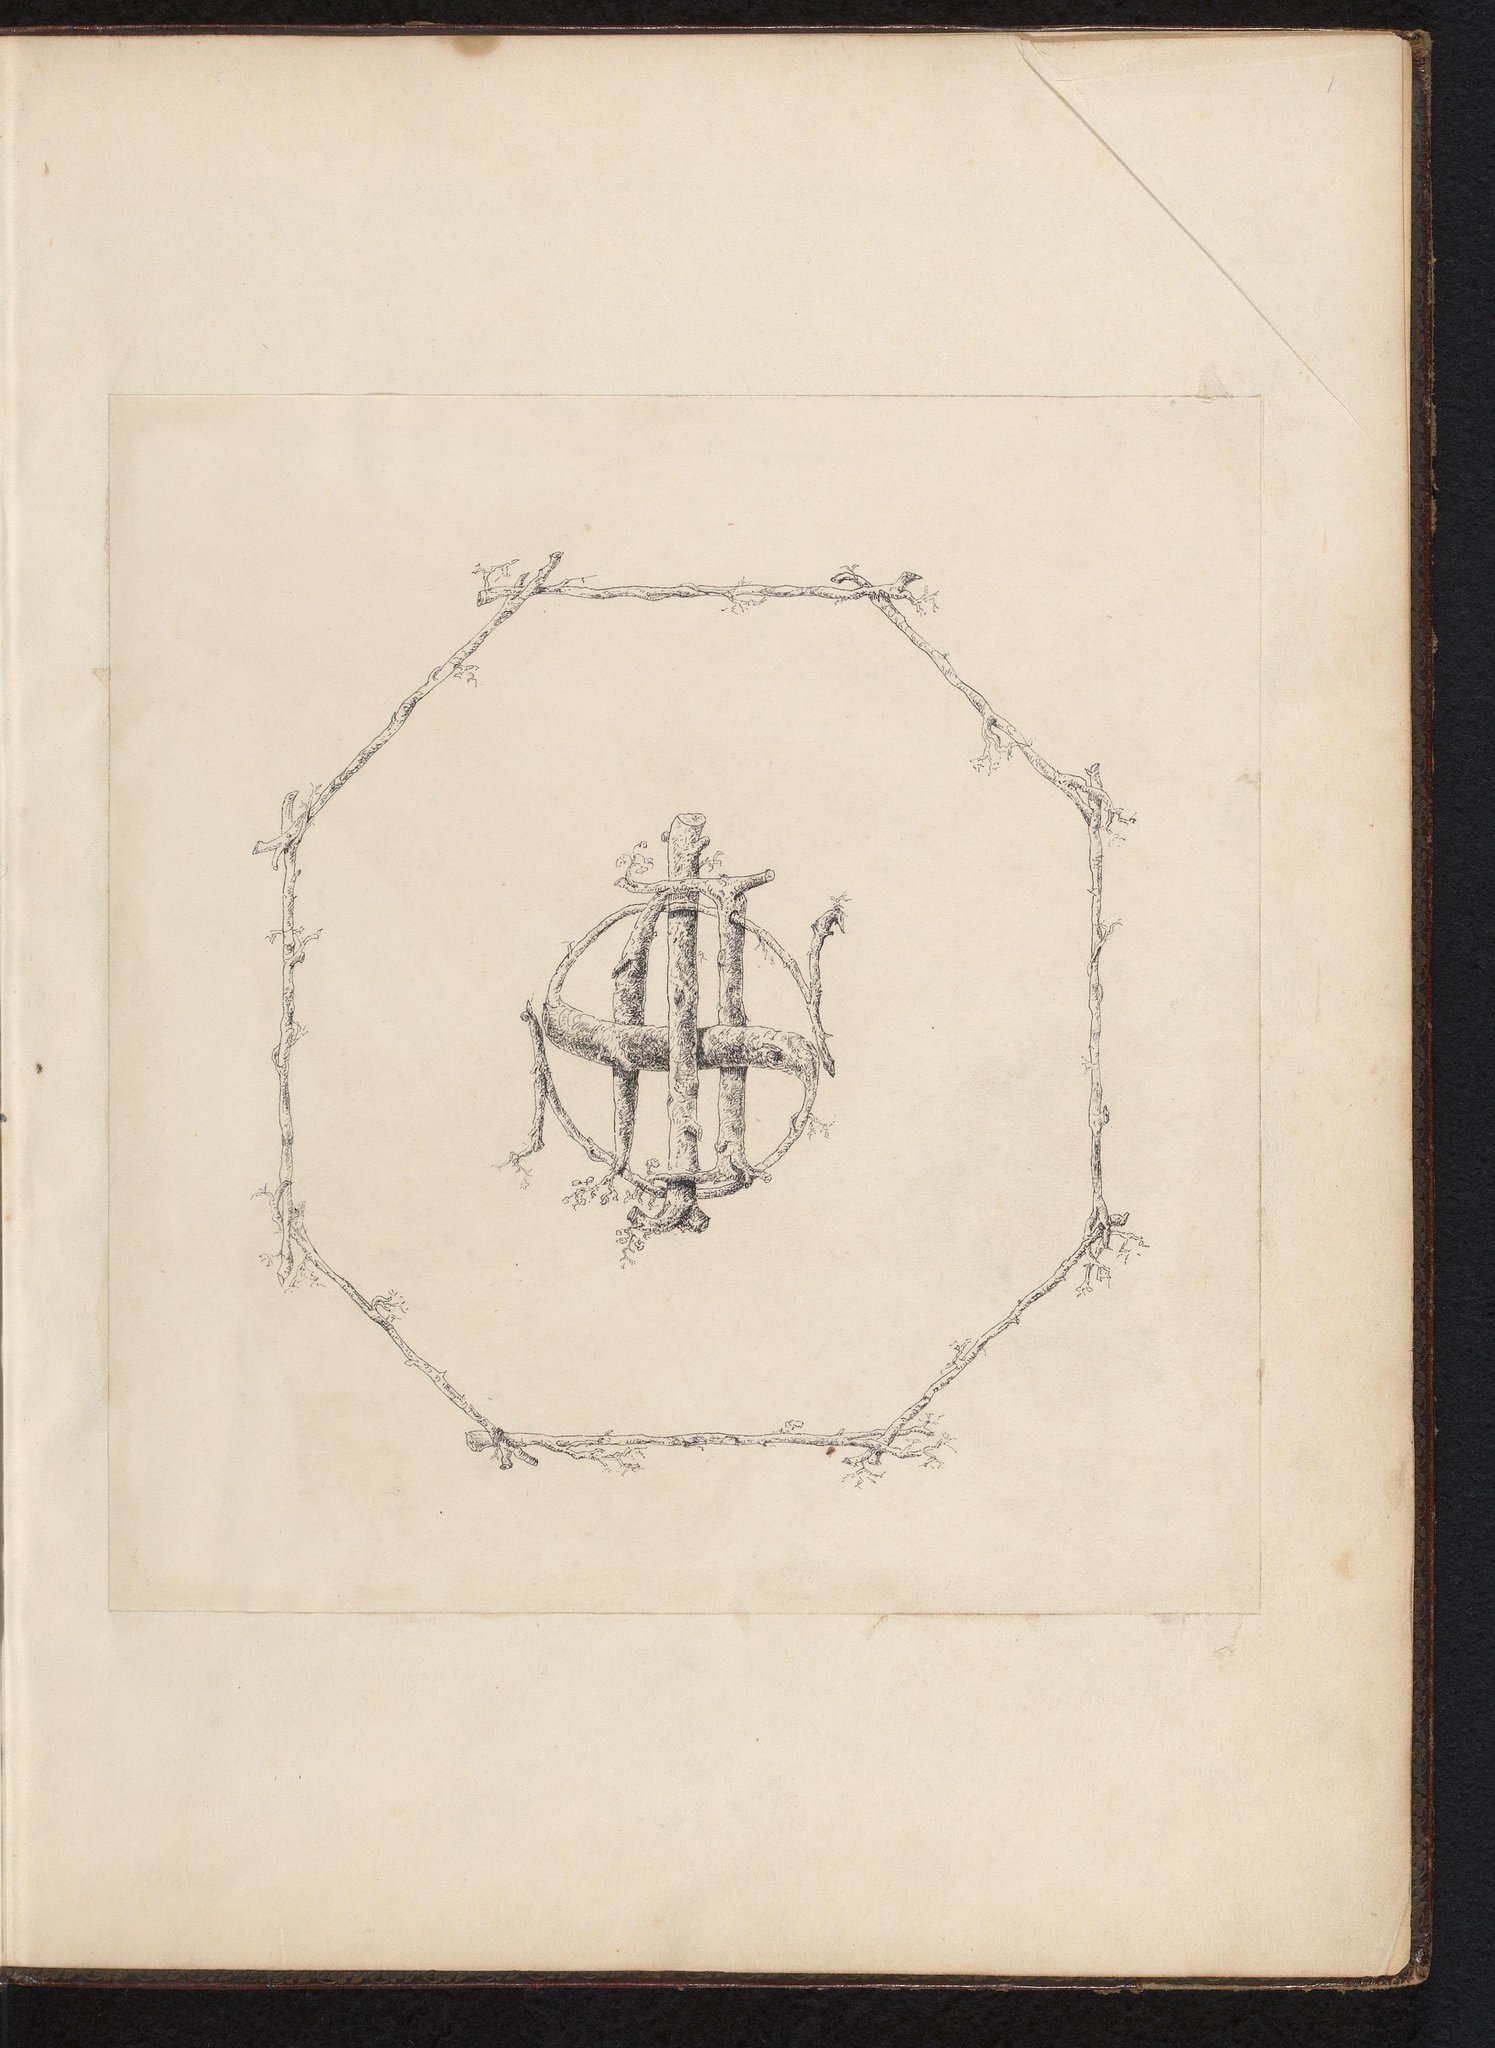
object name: album leaf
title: Ex libris met initialen van I. A. Seward in de vorm van boomstronken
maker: Anonymous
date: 1869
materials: paper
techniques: etching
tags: ornamental plants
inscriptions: inscription: ‘I.A. Seward,/ from’